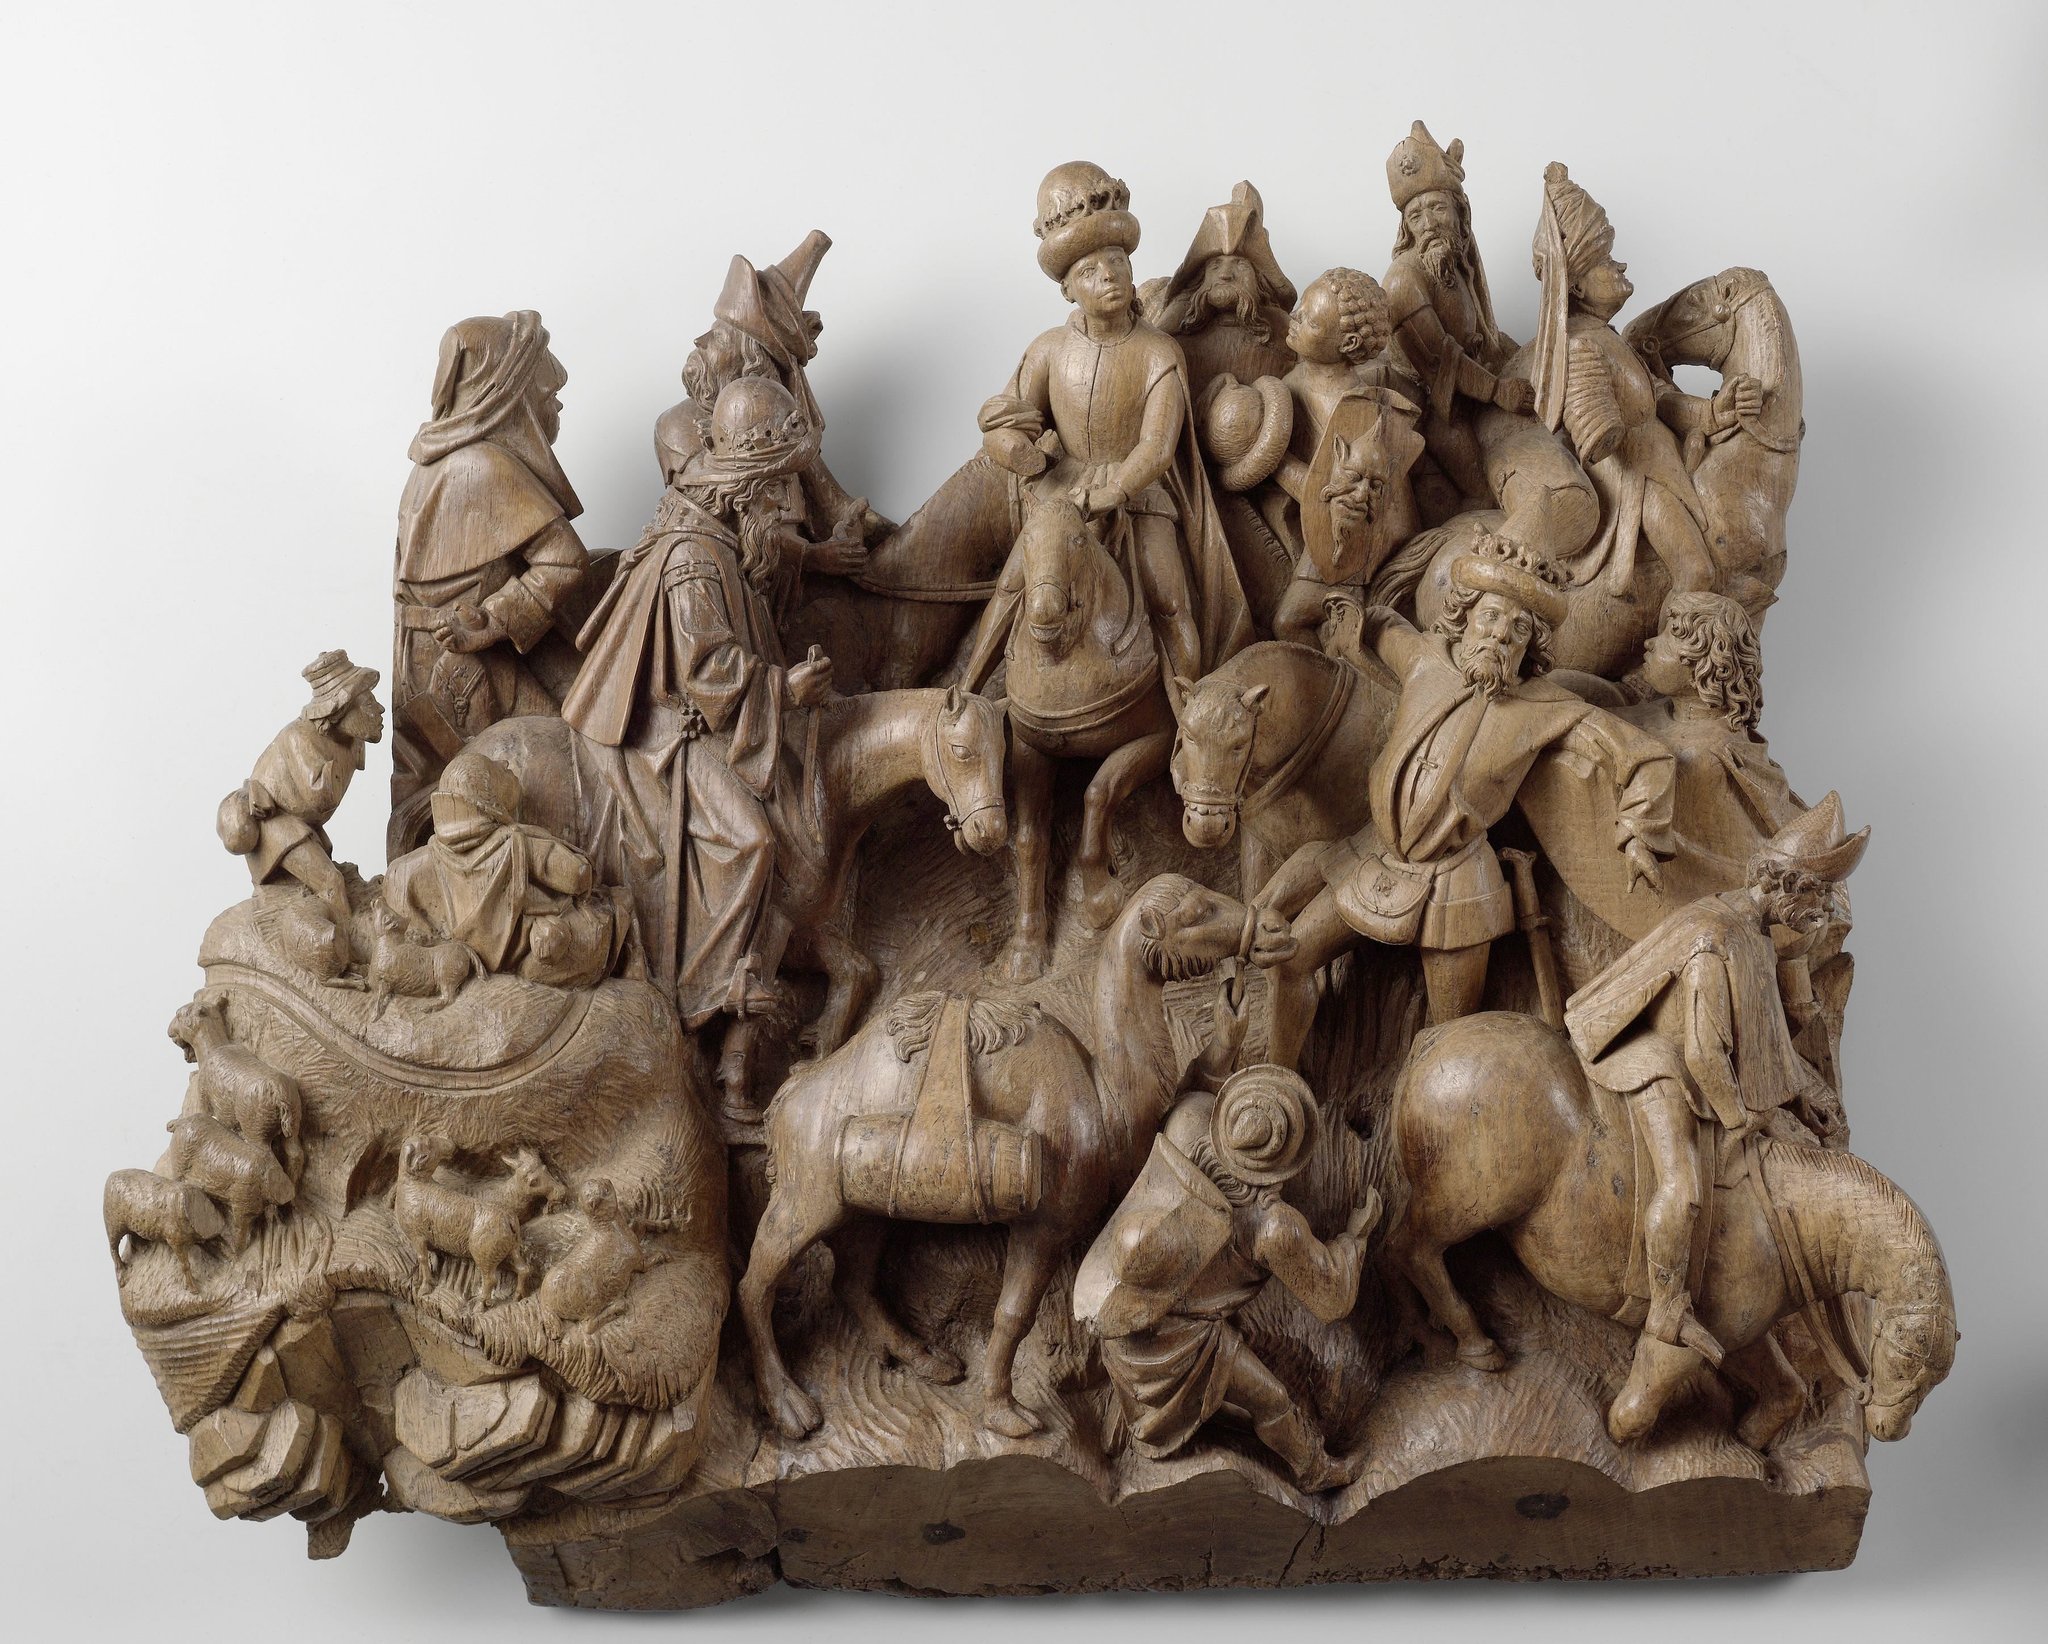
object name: sculpture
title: The Meeting of the Magi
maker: adriaen van wesel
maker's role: sculptor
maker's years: 1415-1490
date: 1475-1477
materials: wood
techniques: cutting, polychromy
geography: utrecht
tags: the three wise men meet at the crossroads, den bosch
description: These figures were part of a large altar in the chapel of the Confraternity of Our Lady in ‘s Hertogenbosch. This was a highly innovative altar, with its lively, expressive scenes and figures. Five fragments are arranged here in their original order. The adoration of the newborn Child (now missing) by the Virgin, Joseph and the angels was at the very centre of the altar.